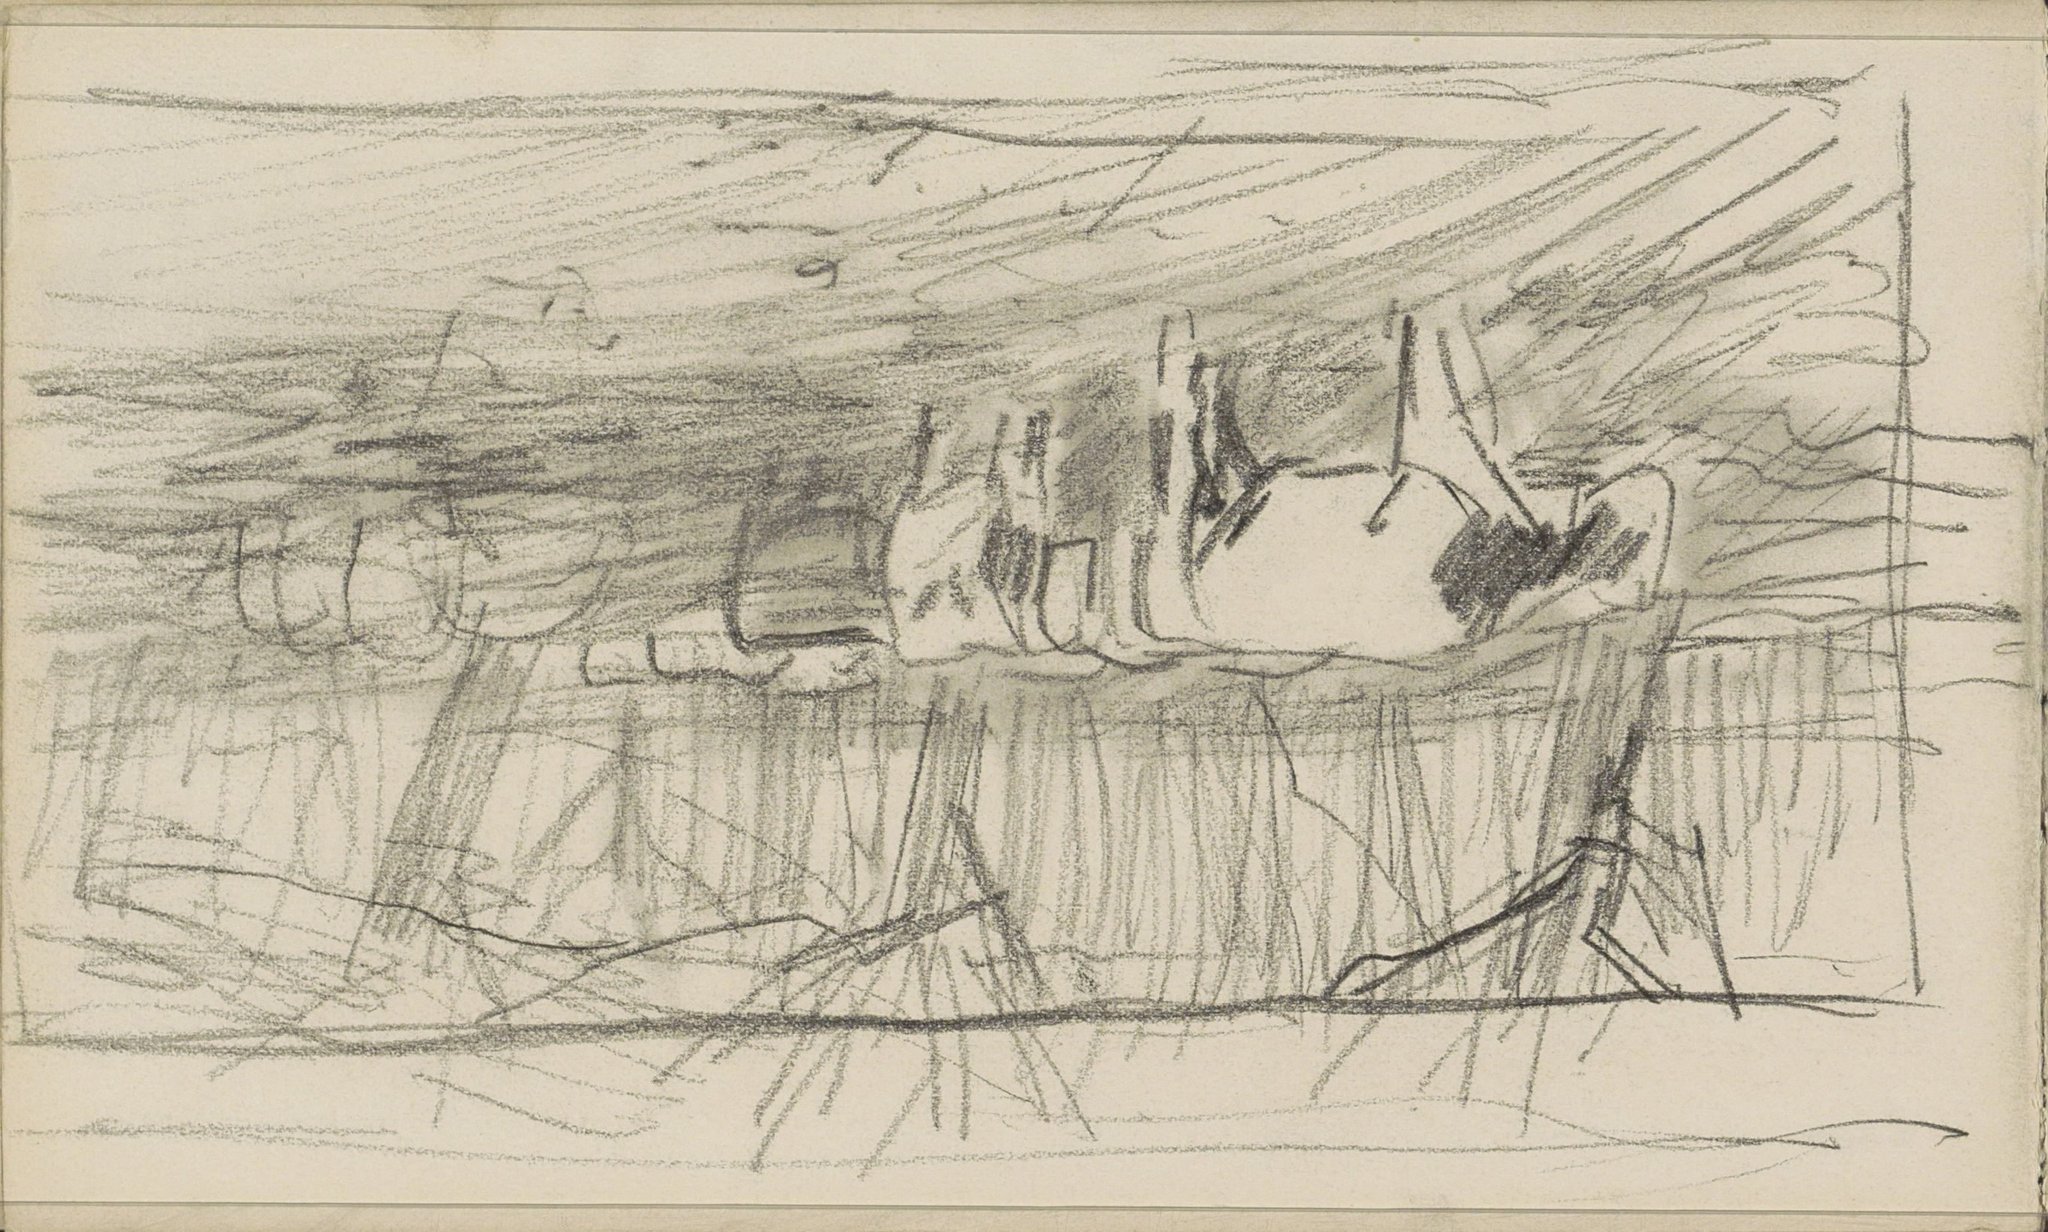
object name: sketchbook leaf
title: Koeien in een weiland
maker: anton mauve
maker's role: draughtsman, painter, print maker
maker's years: 1838-1888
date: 1848-1888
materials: chalk, paper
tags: cow, meadow, pasture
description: Blad 10 verso uit een schetsboek met 33 bladen.